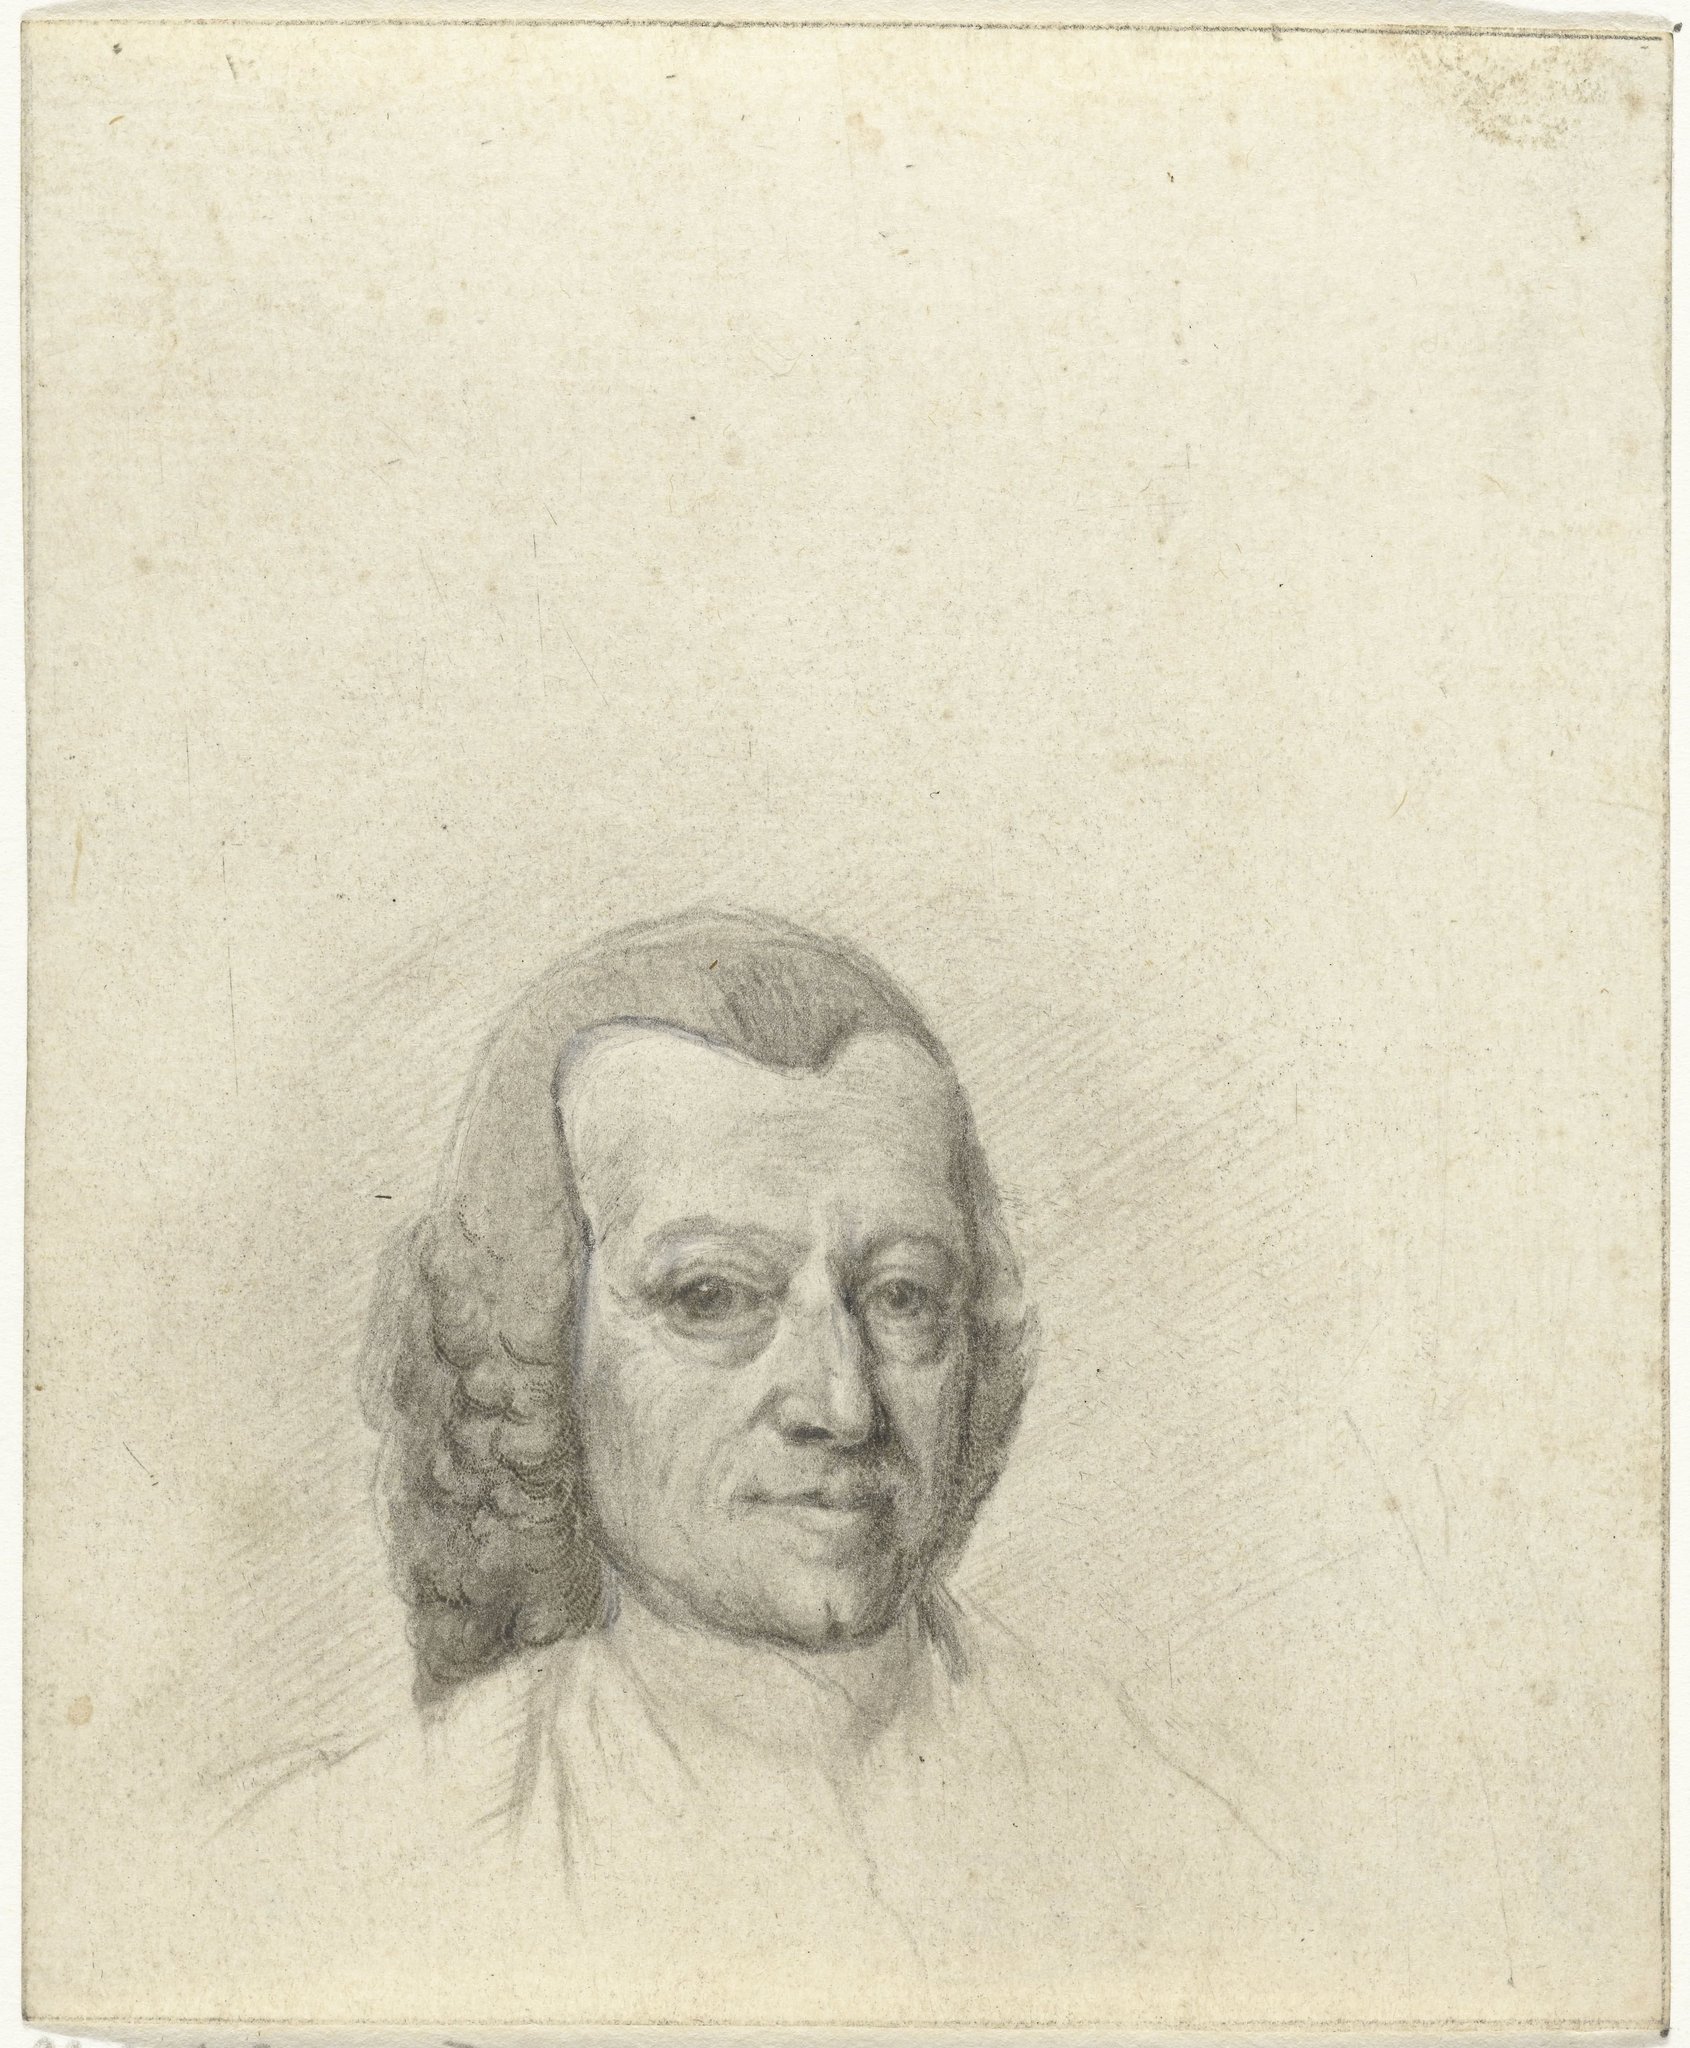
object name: print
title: Zelfportret van Jurriaan Cootwijck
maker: jurriaan cootwijck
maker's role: print maker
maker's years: 1714-1798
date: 1724-1798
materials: paper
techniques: print drawing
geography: amsterdam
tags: jurriaan cootwijck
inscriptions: collector's mark: Lugt 2228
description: Hoofd van Jurriaan Cootwijck. Gezicht licht naar rechts.